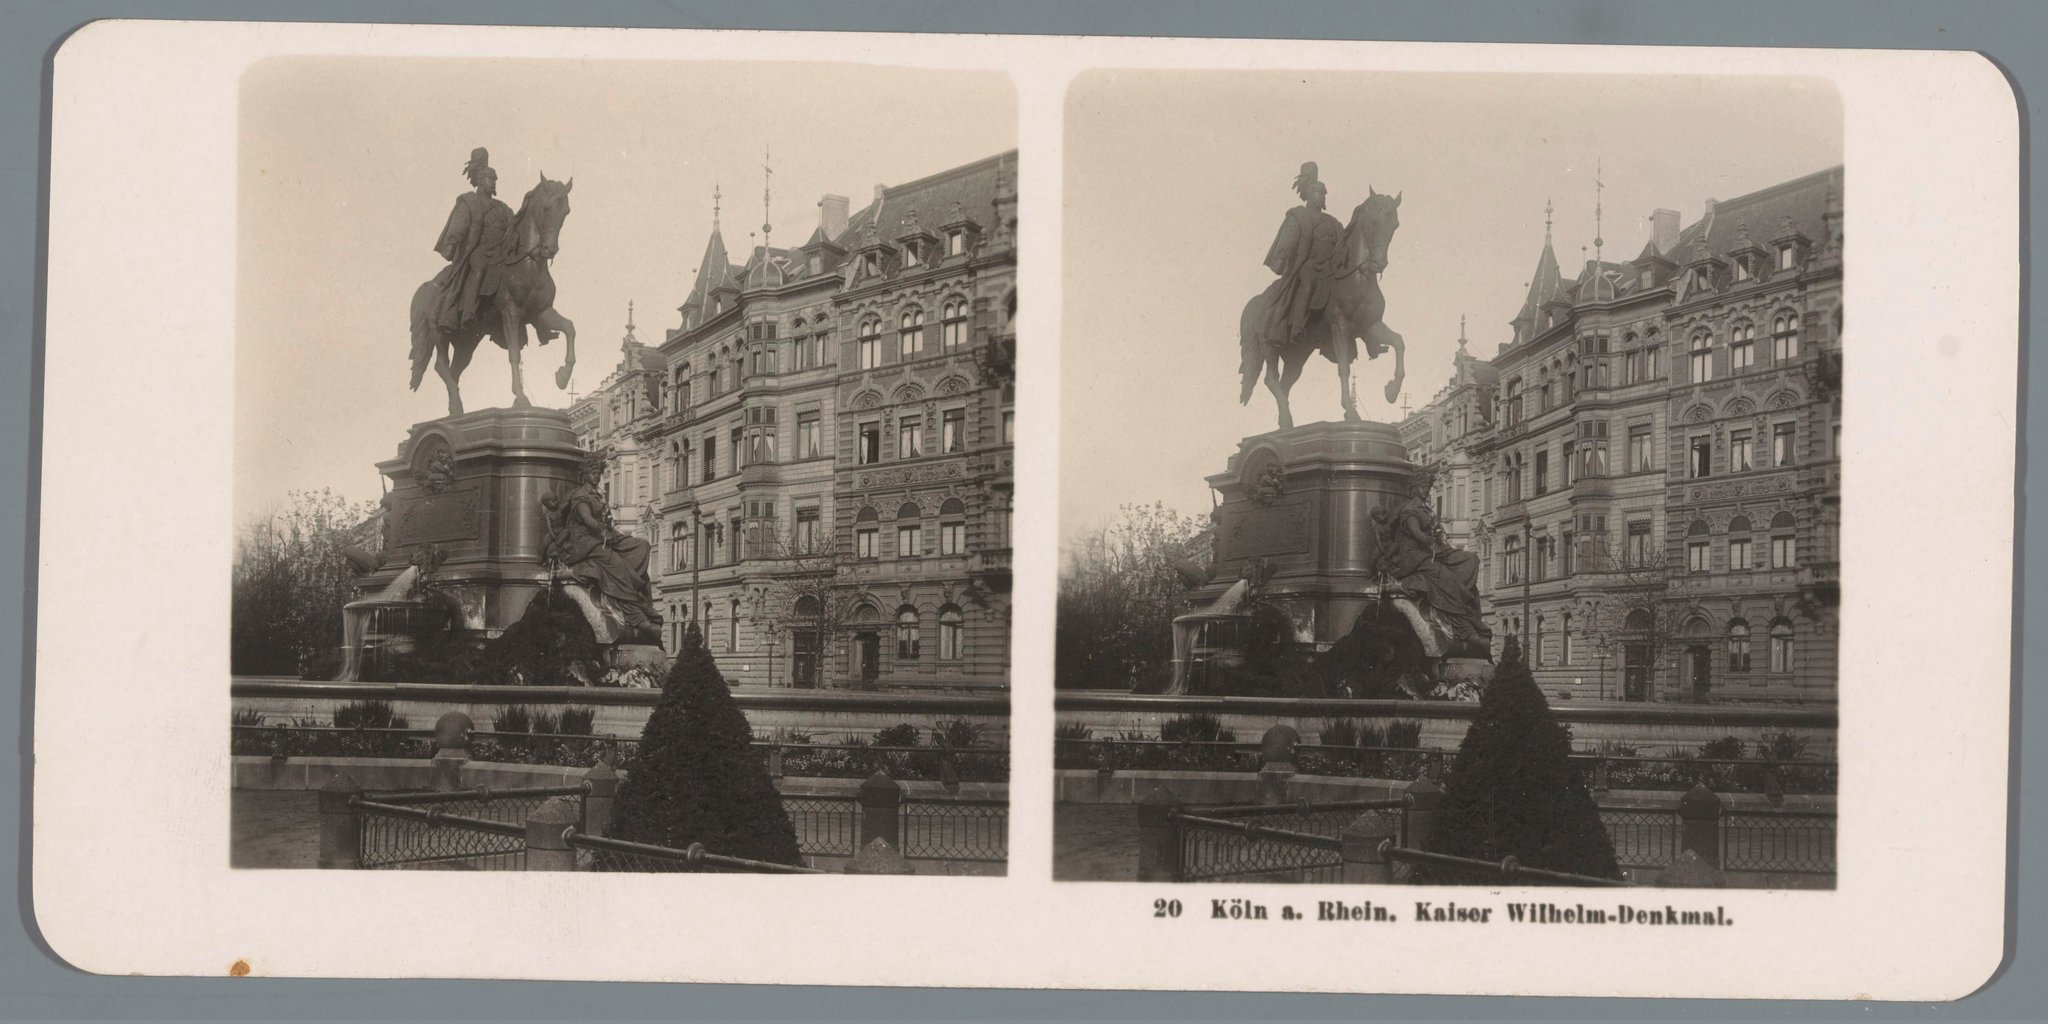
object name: stereograph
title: Ruiterstandbeeld van keizer Wilhelm I van Duitsland te Keulen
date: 1906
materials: cardboard, photographic support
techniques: gelatin silver print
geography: cologne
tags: equestrian statue, façade (of house or building)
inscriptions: number: ‘20’, inscription: ‘Neue Photographische Gesellschaft A. G., Steglitz-Berlin 1906.’